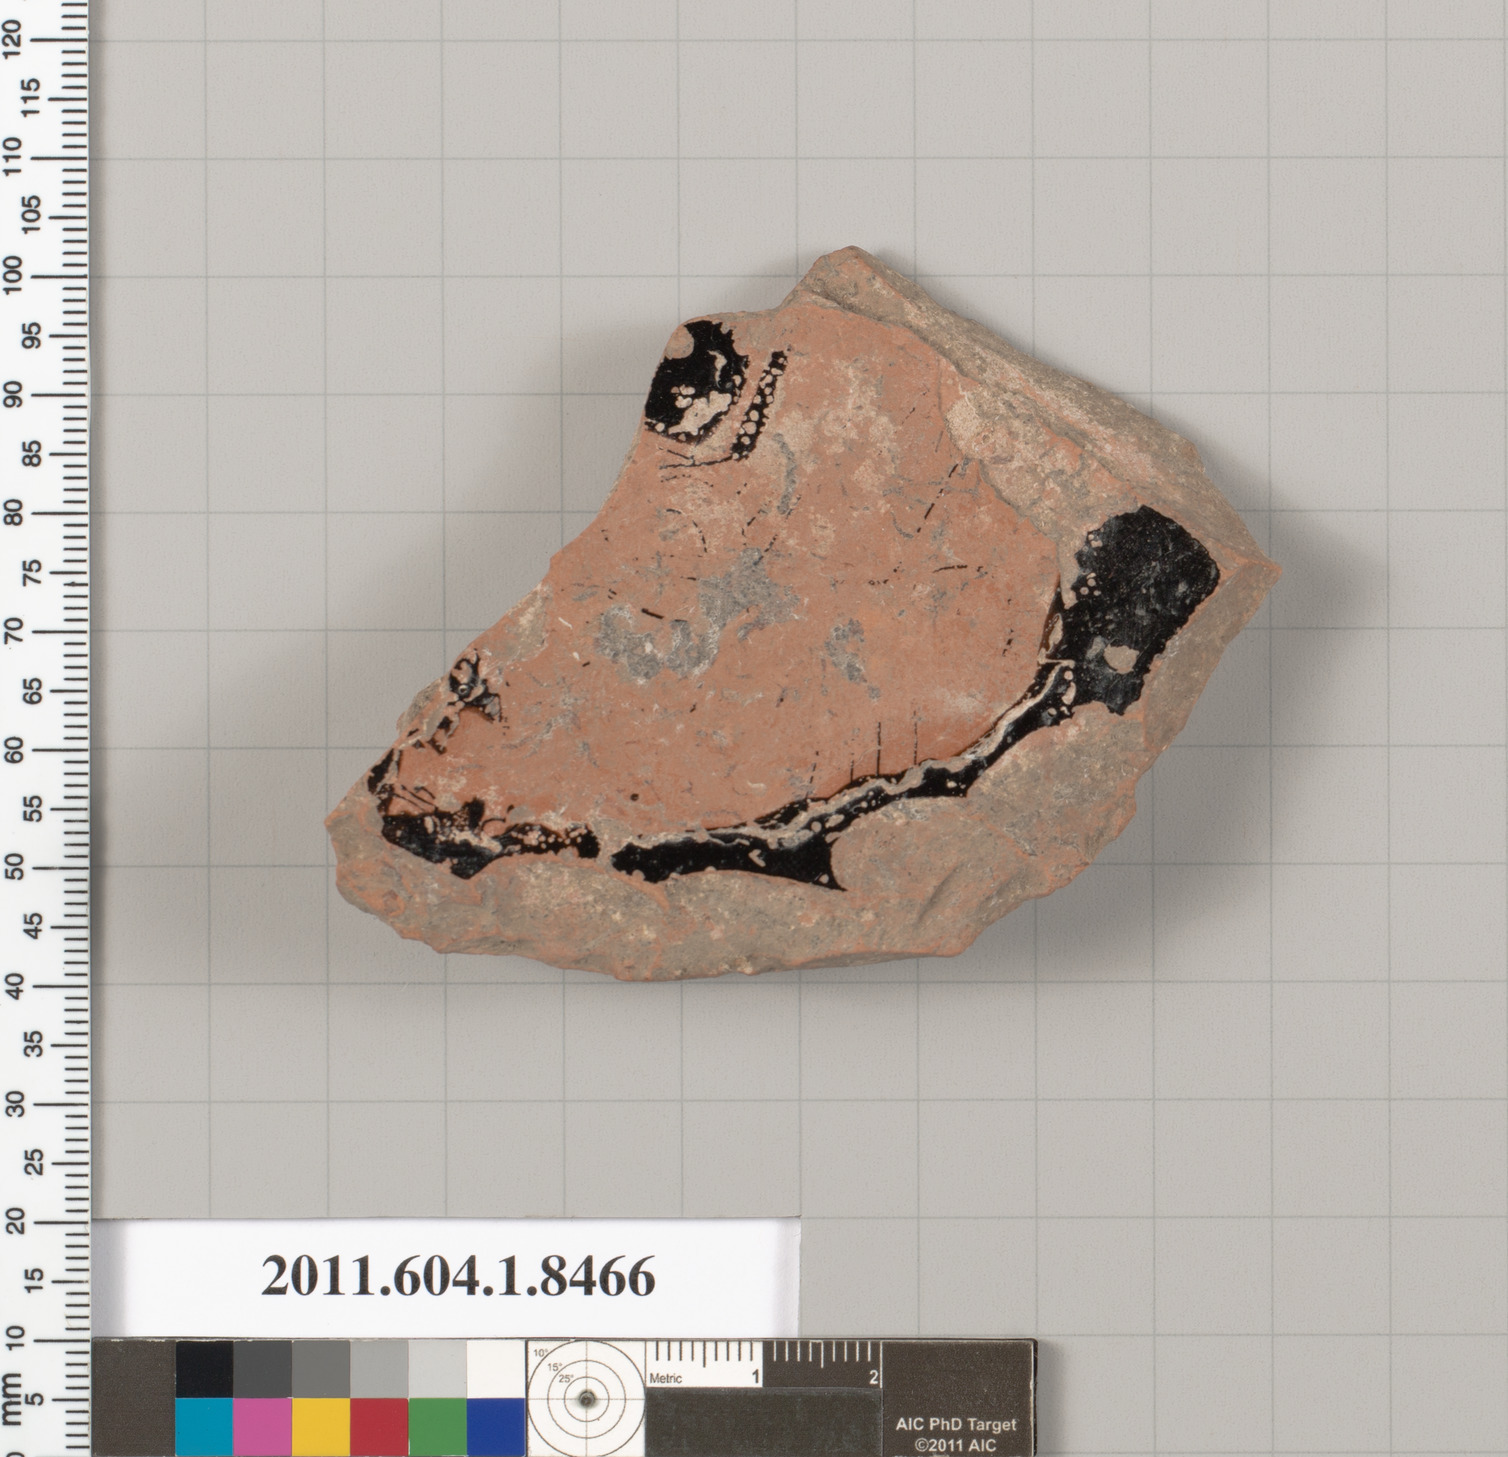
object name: kylix fragment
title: Terracotta fragment of a stemless kylix (drinking cup)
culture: greek, attic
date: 475-451 BCE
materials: terracotta